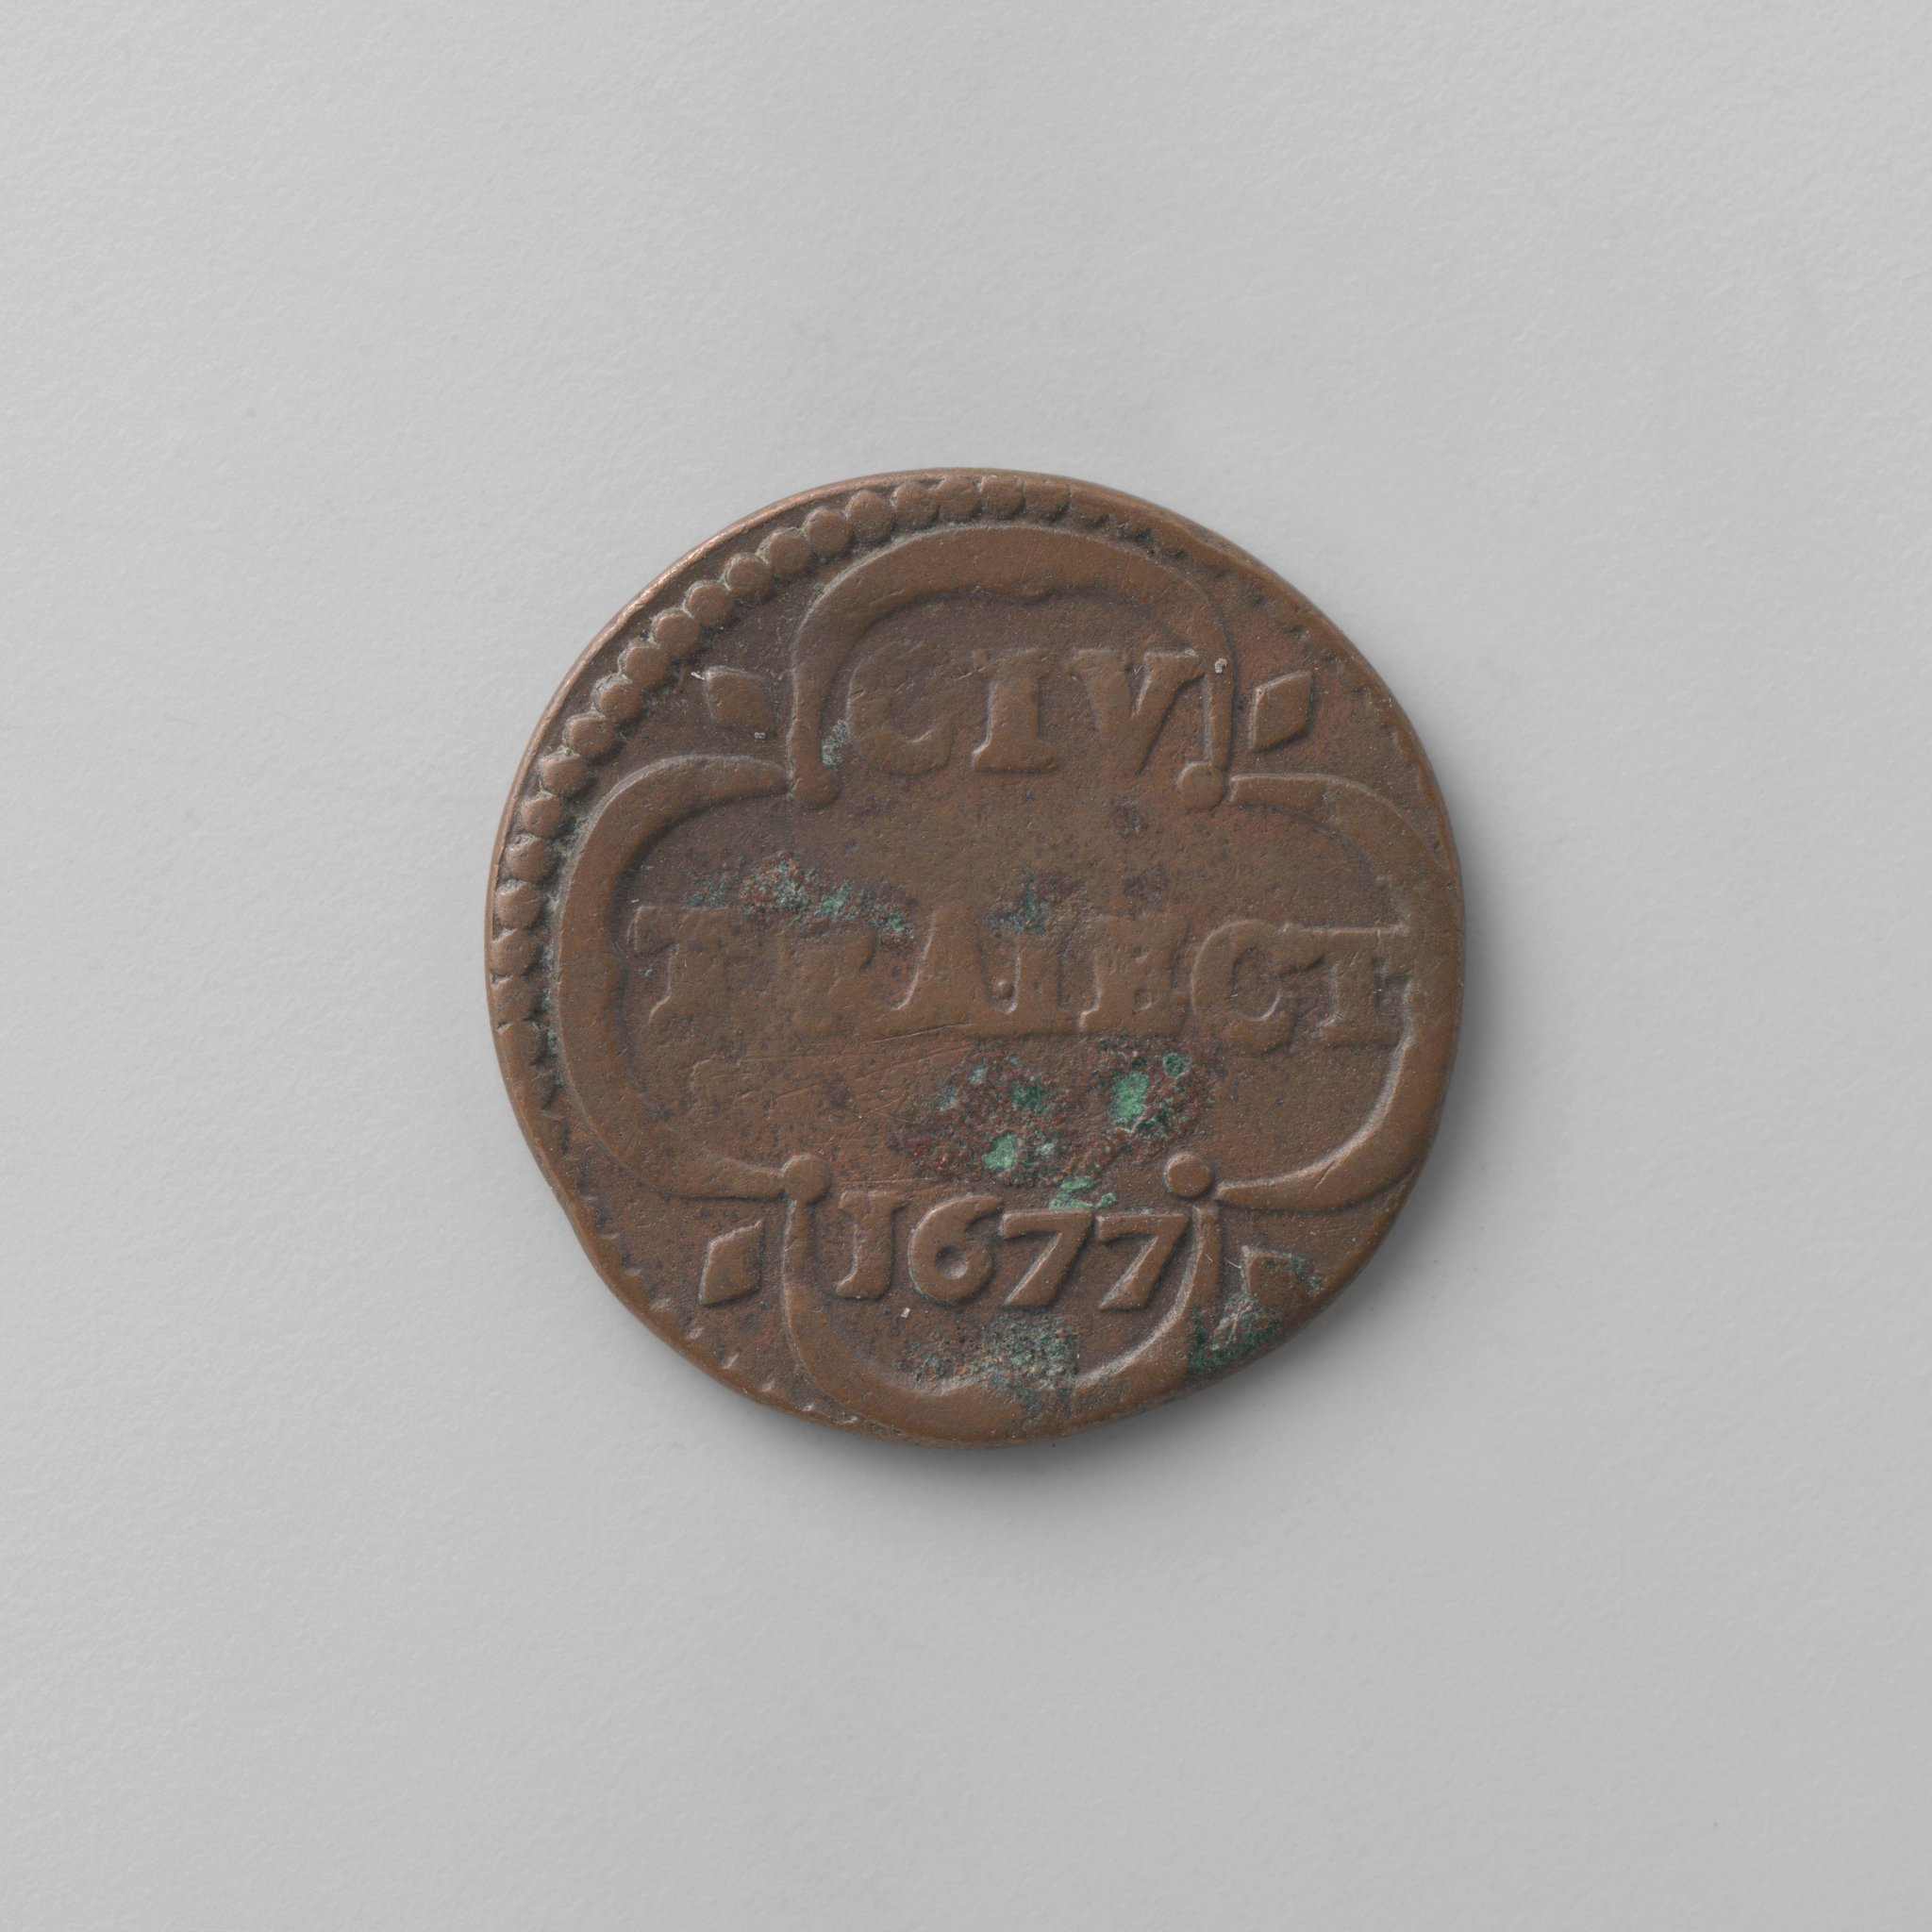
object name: coin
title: Stad Utrecht, duit, 1677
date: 1677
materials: copper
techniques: striking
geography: utrecht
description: Koperen munt. Voorzijde: gekroond stedelijk, horizontaal gearceeerd wapenschild, gehouden door twee leeuwen. Keerzijde: binnen een versierde vierpas opschrift in twee regels, waaronder jaartal.